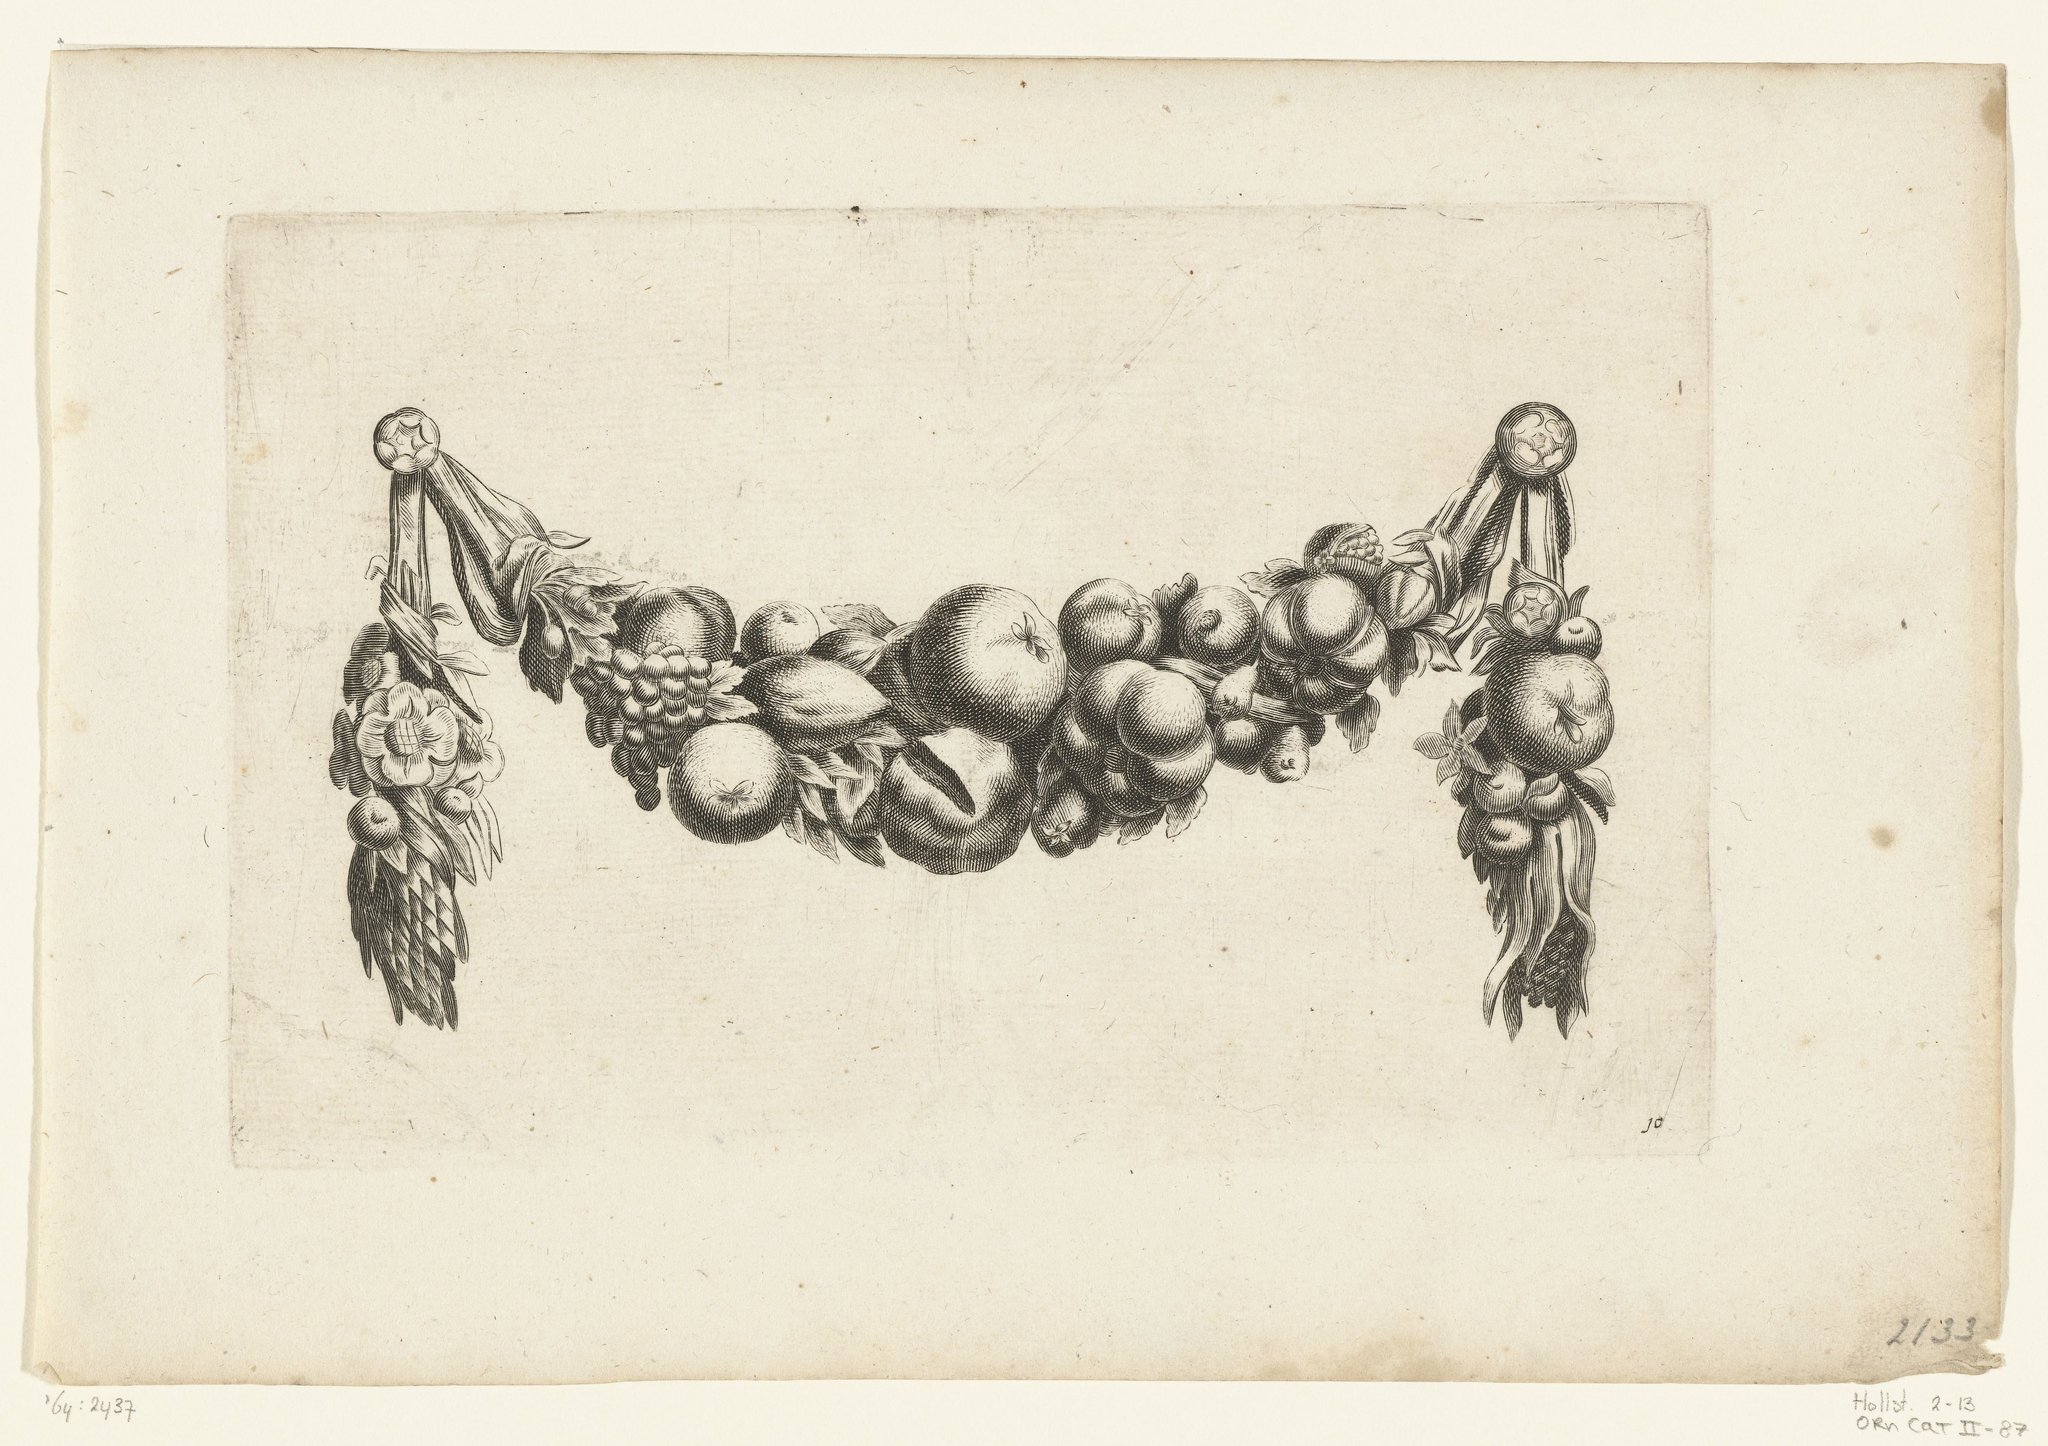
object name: ornament print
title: Festoen van fruit, met granaatappels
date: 1655-1678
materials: paper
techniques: engraving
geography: amsterdam